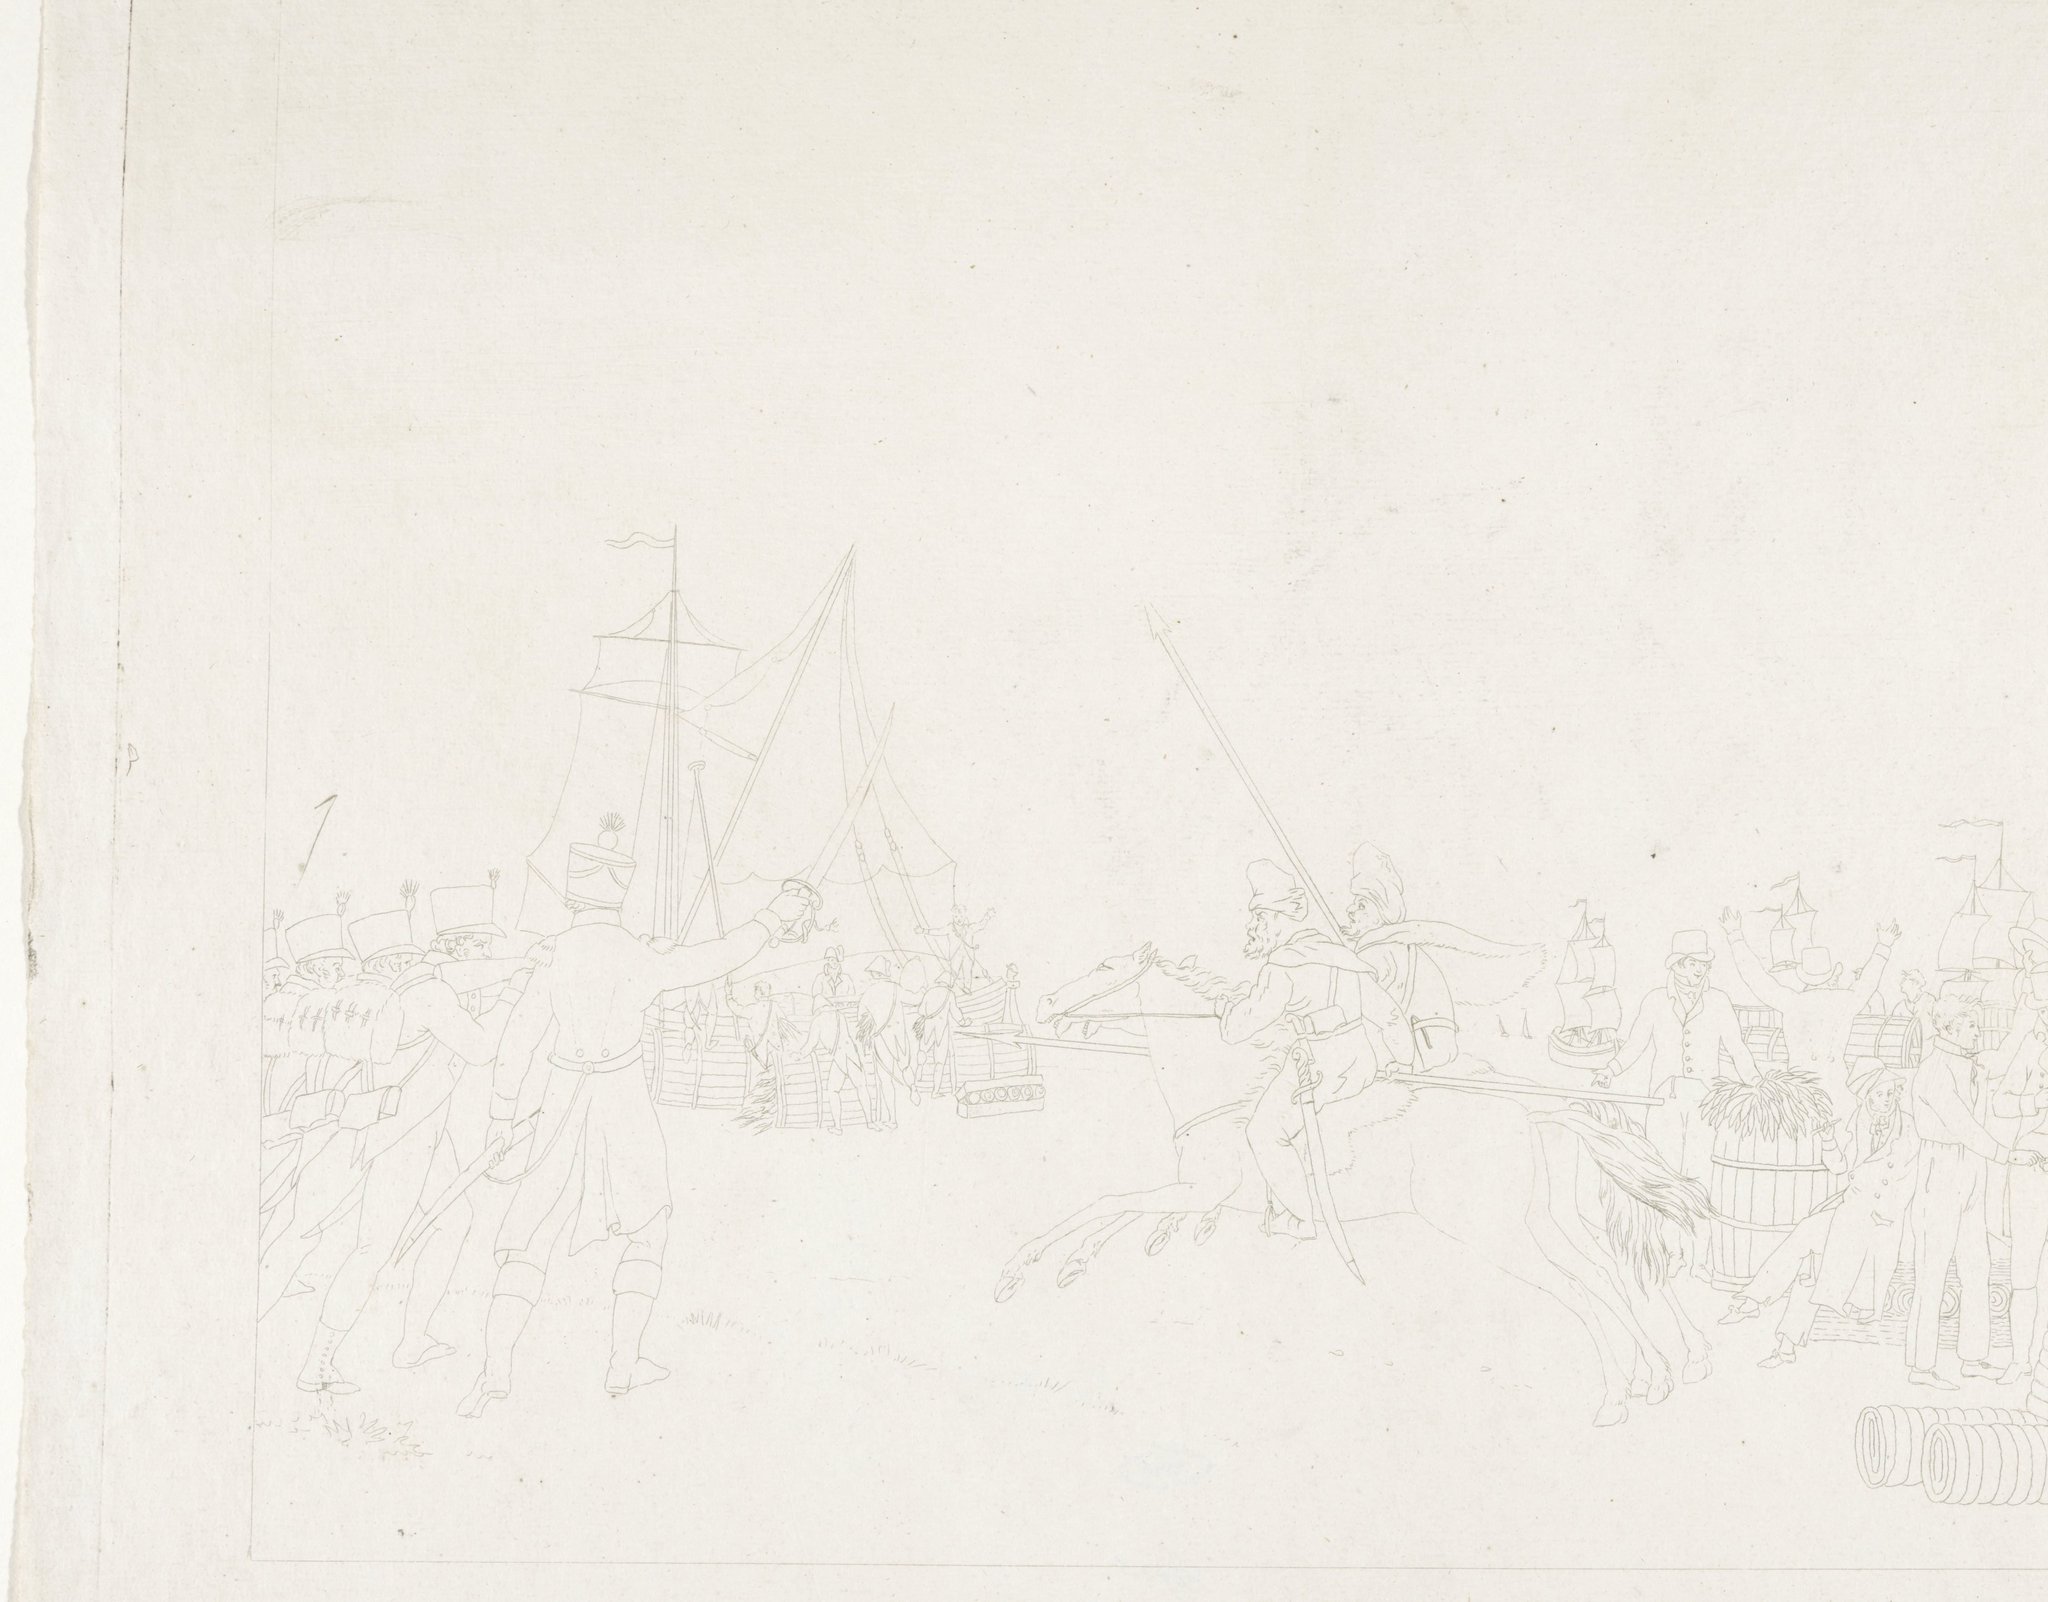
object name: print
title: Spotprent op de Franse Douanen, 1813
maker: Anonymous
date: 1813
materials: paper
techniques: etching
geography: netherlands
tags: customs, tobacco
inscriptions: collector's mark: Lugt 2228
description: Spotprent op de vlucht van de Franse douanen, met hun belemmering op de verkoop van tabak, uit Nederland na de val van de Fransen, 1813. Rechts op de kade geniet een groep Nederlanders tevreden van tabak ingevoerd uit Amerika. Centraal stormen twee kozakken te paard af op de groep Franse douanen die in een schip vluchten met hun regie-tabak, links oprukkende Nederlandse soldaten.